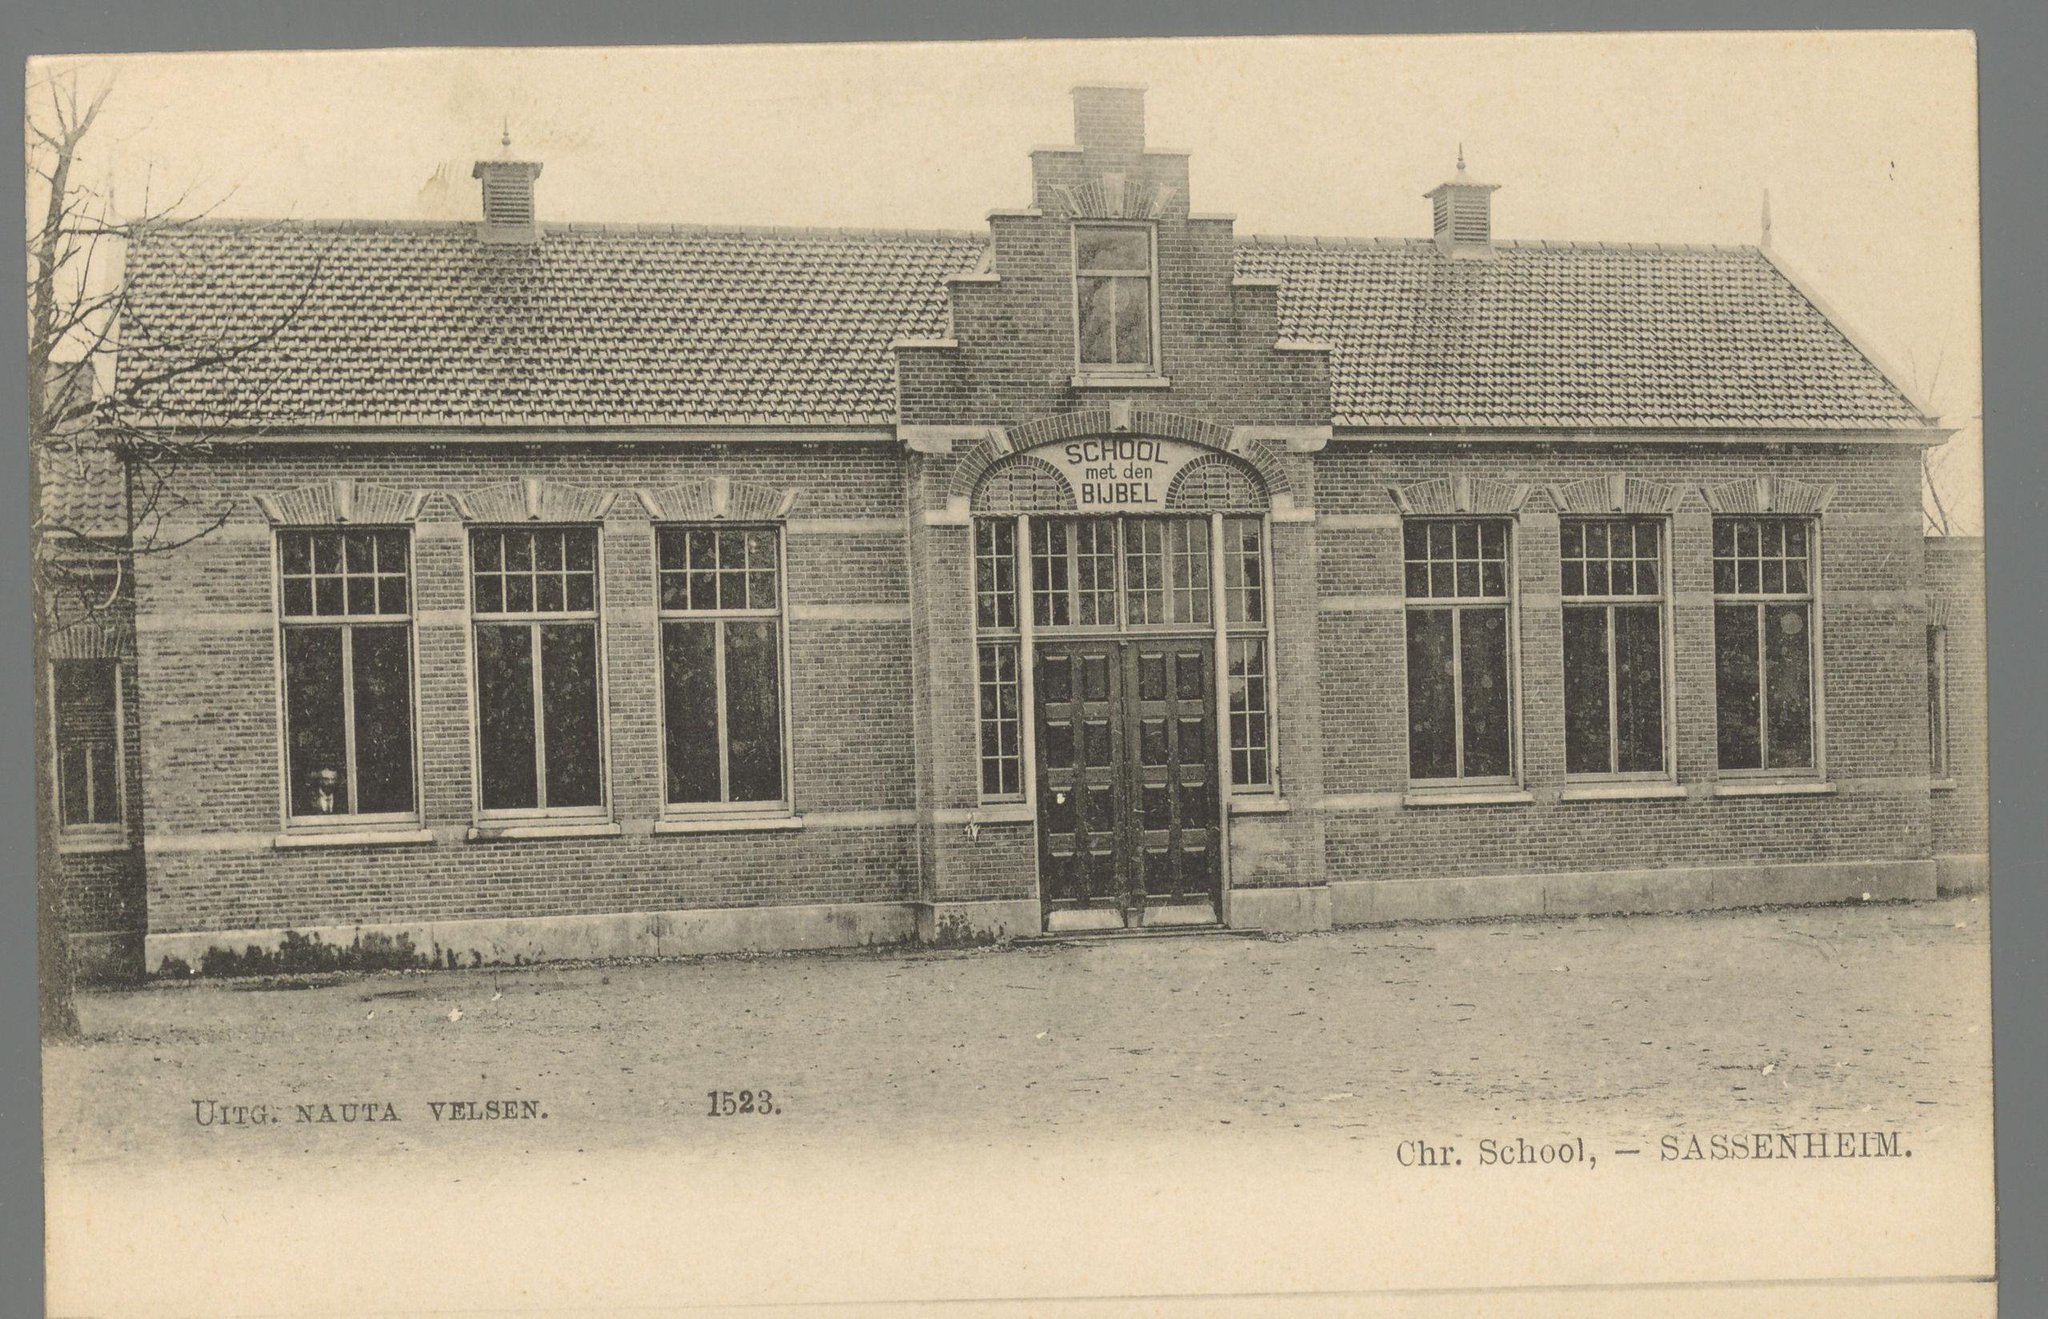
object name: photomechanical print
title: Chr. school, - Sassenheim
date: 1897-1905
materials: cardboard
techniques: photograph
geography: sassenheim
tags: elementary school; class, form